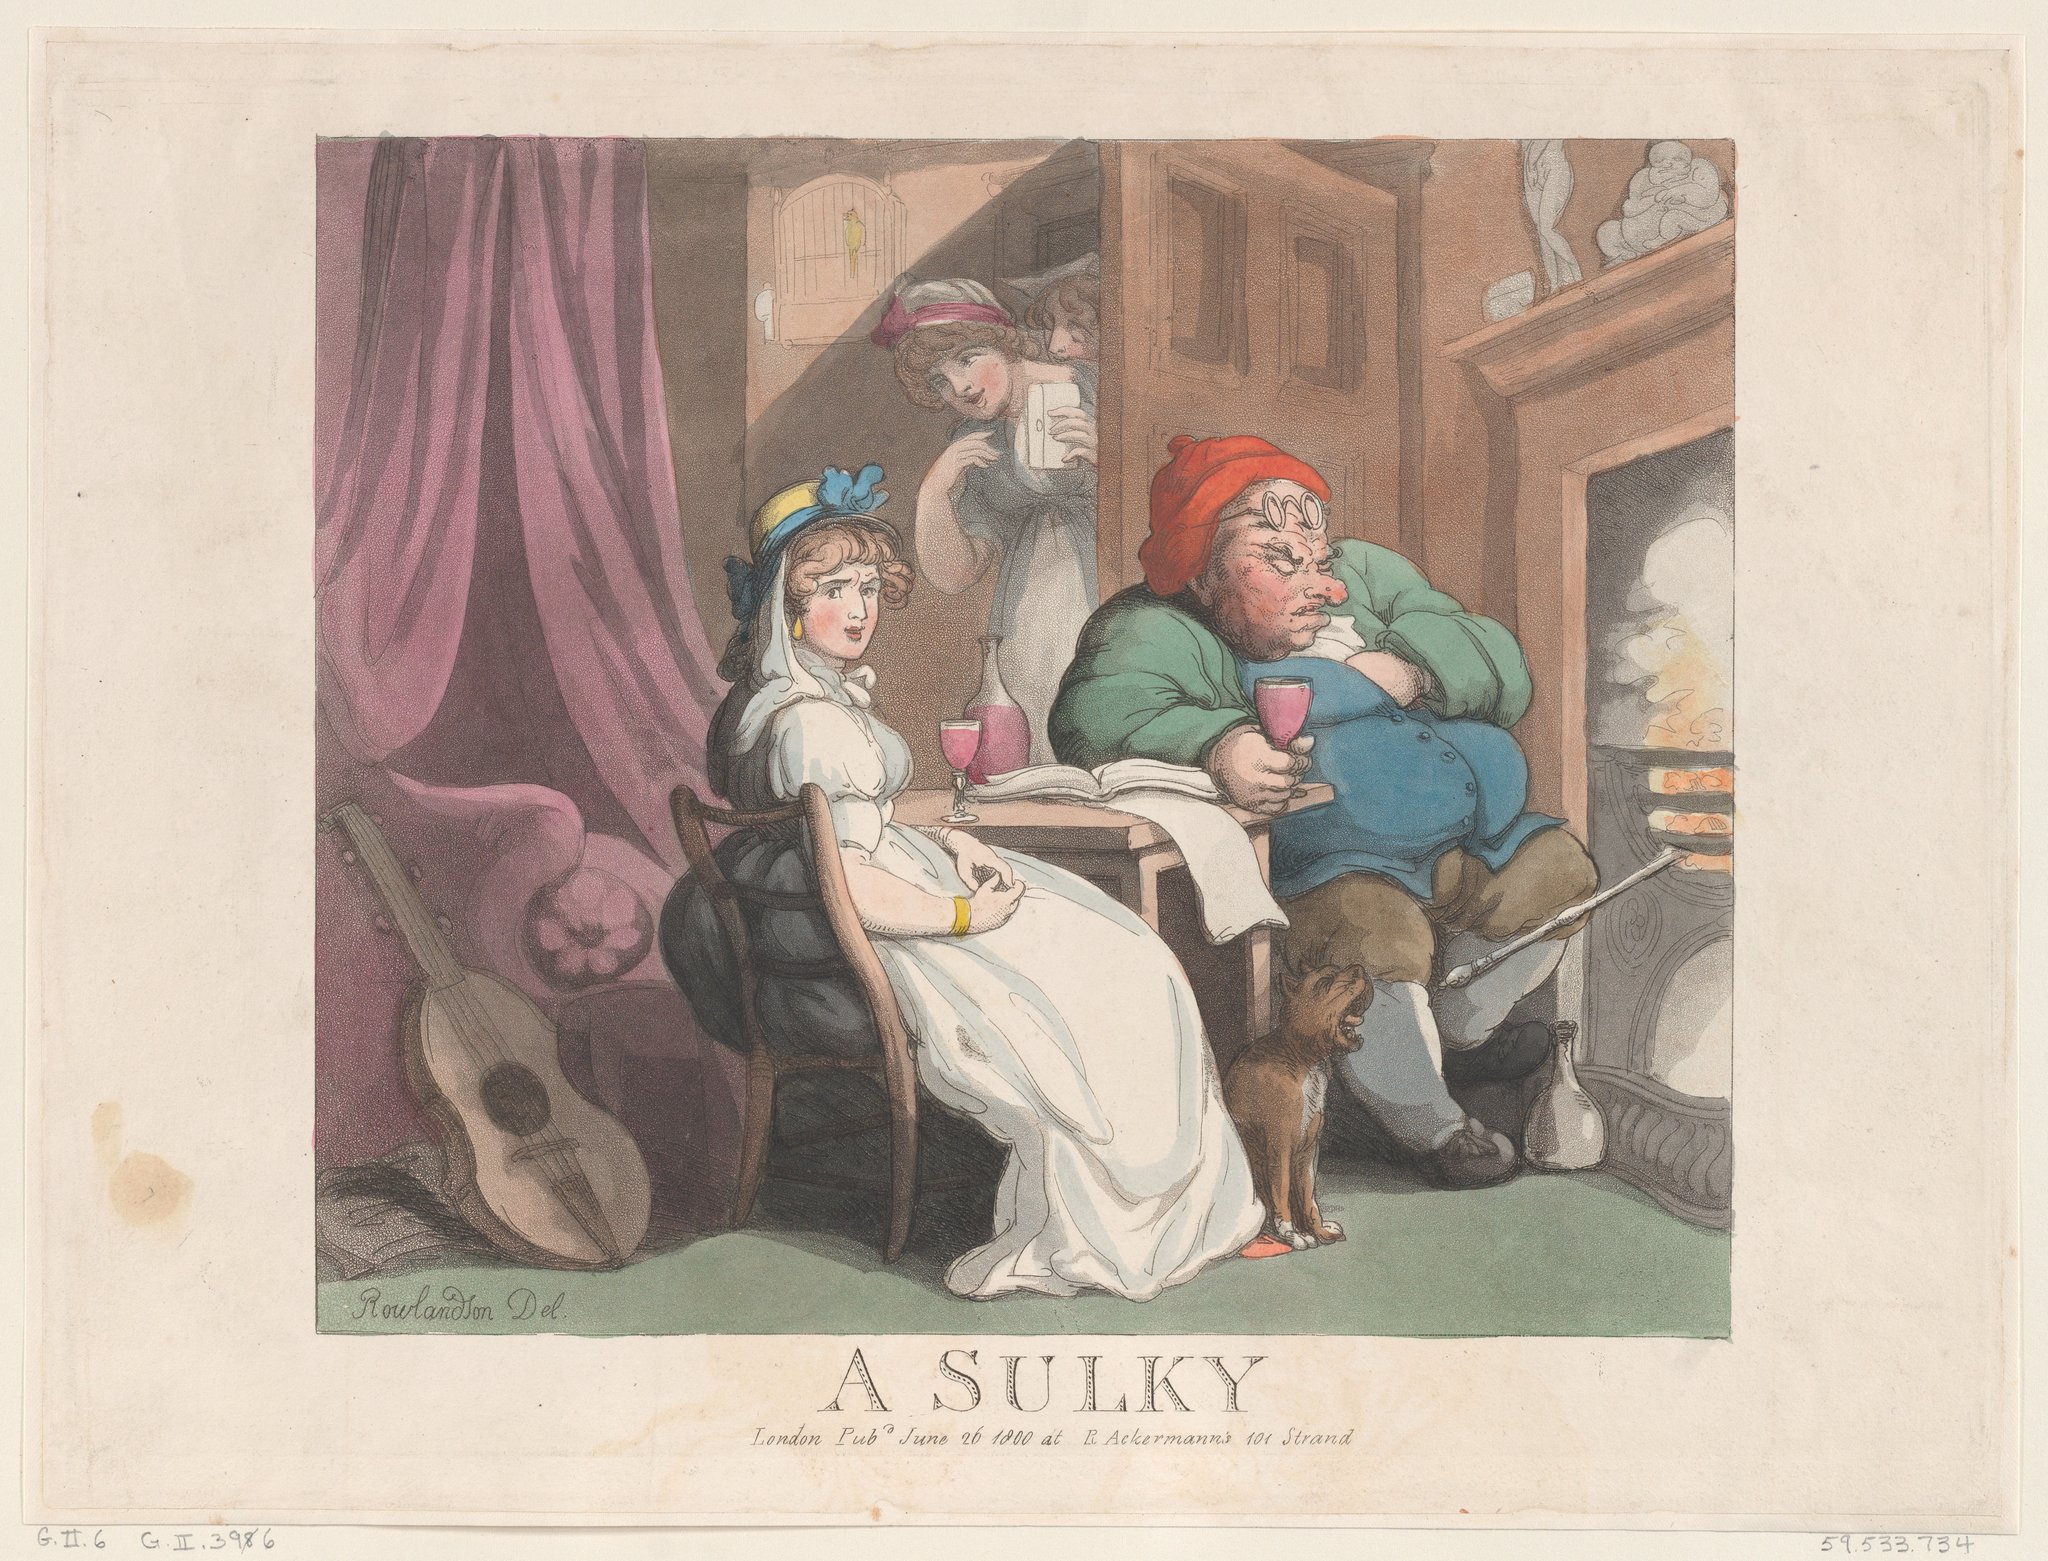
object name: print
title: A Silly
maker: thomas rowlandson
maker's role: artist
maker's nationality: british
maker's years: 1757-1827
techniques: aquatint, etching, hand coloring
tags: men